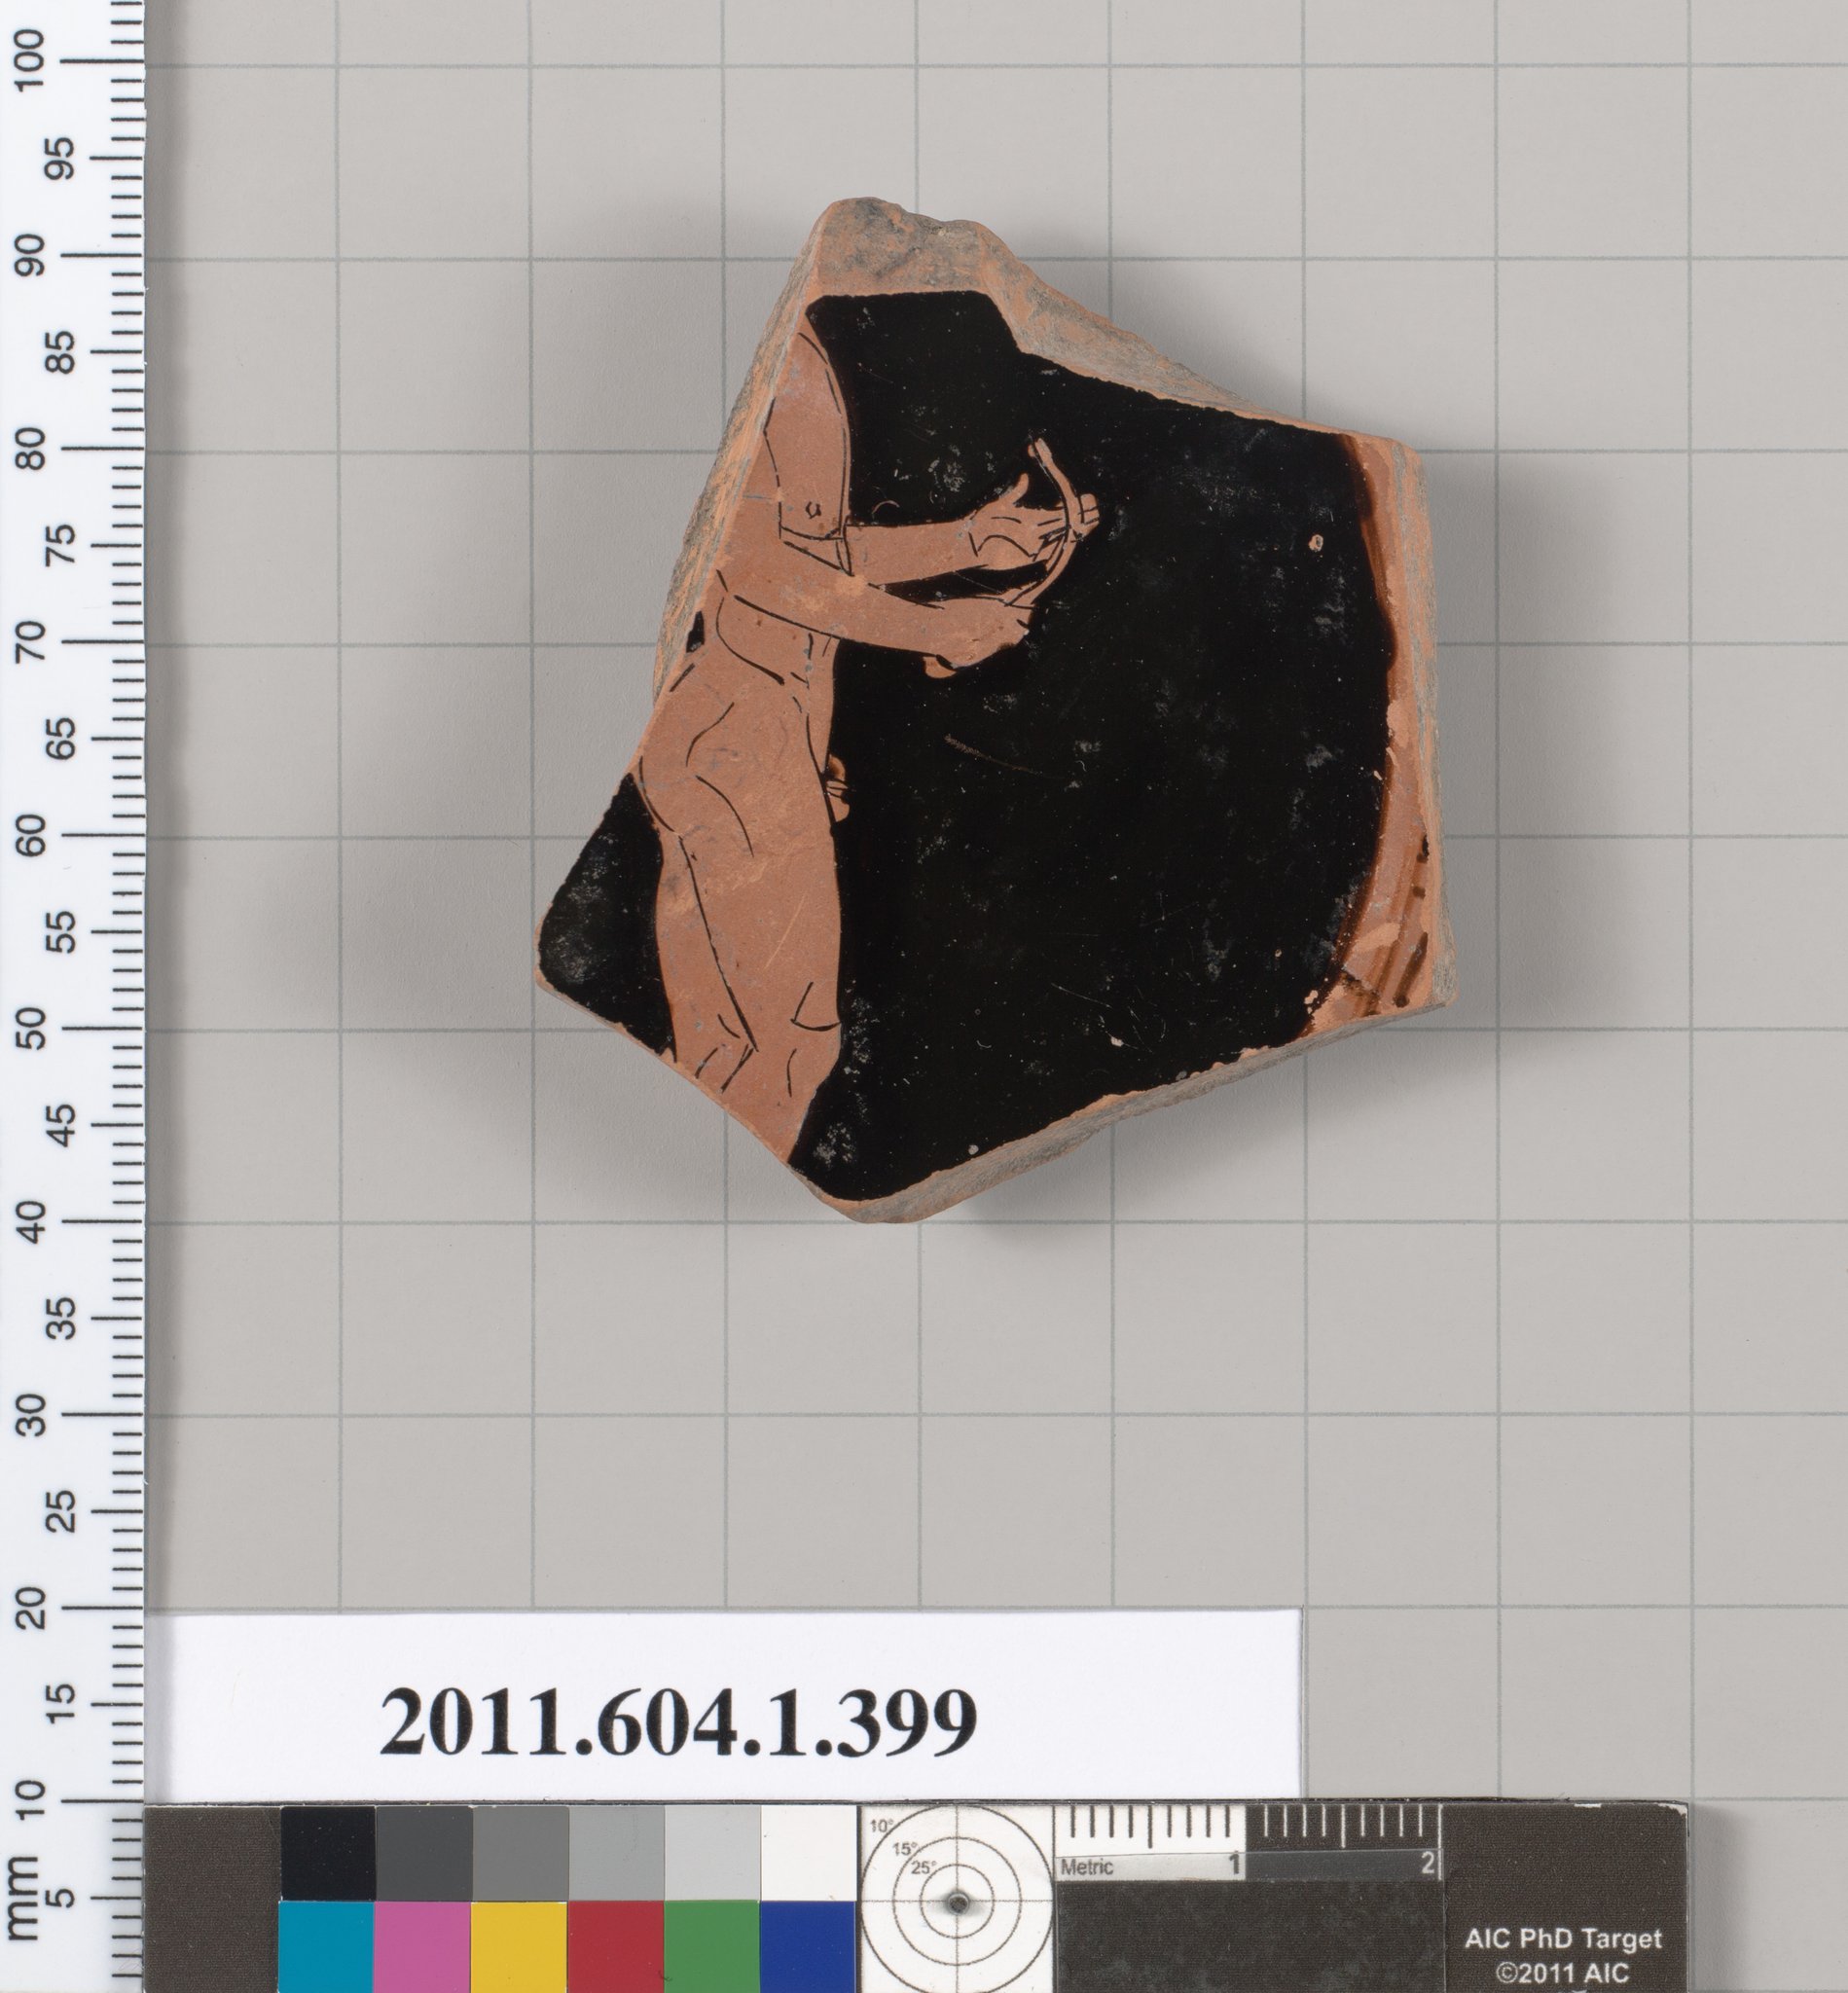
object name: kylix fragment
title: Terracotta fragment of a kylix (drinking cup)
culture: greek, attic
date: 475-451 BCE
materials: terracotta